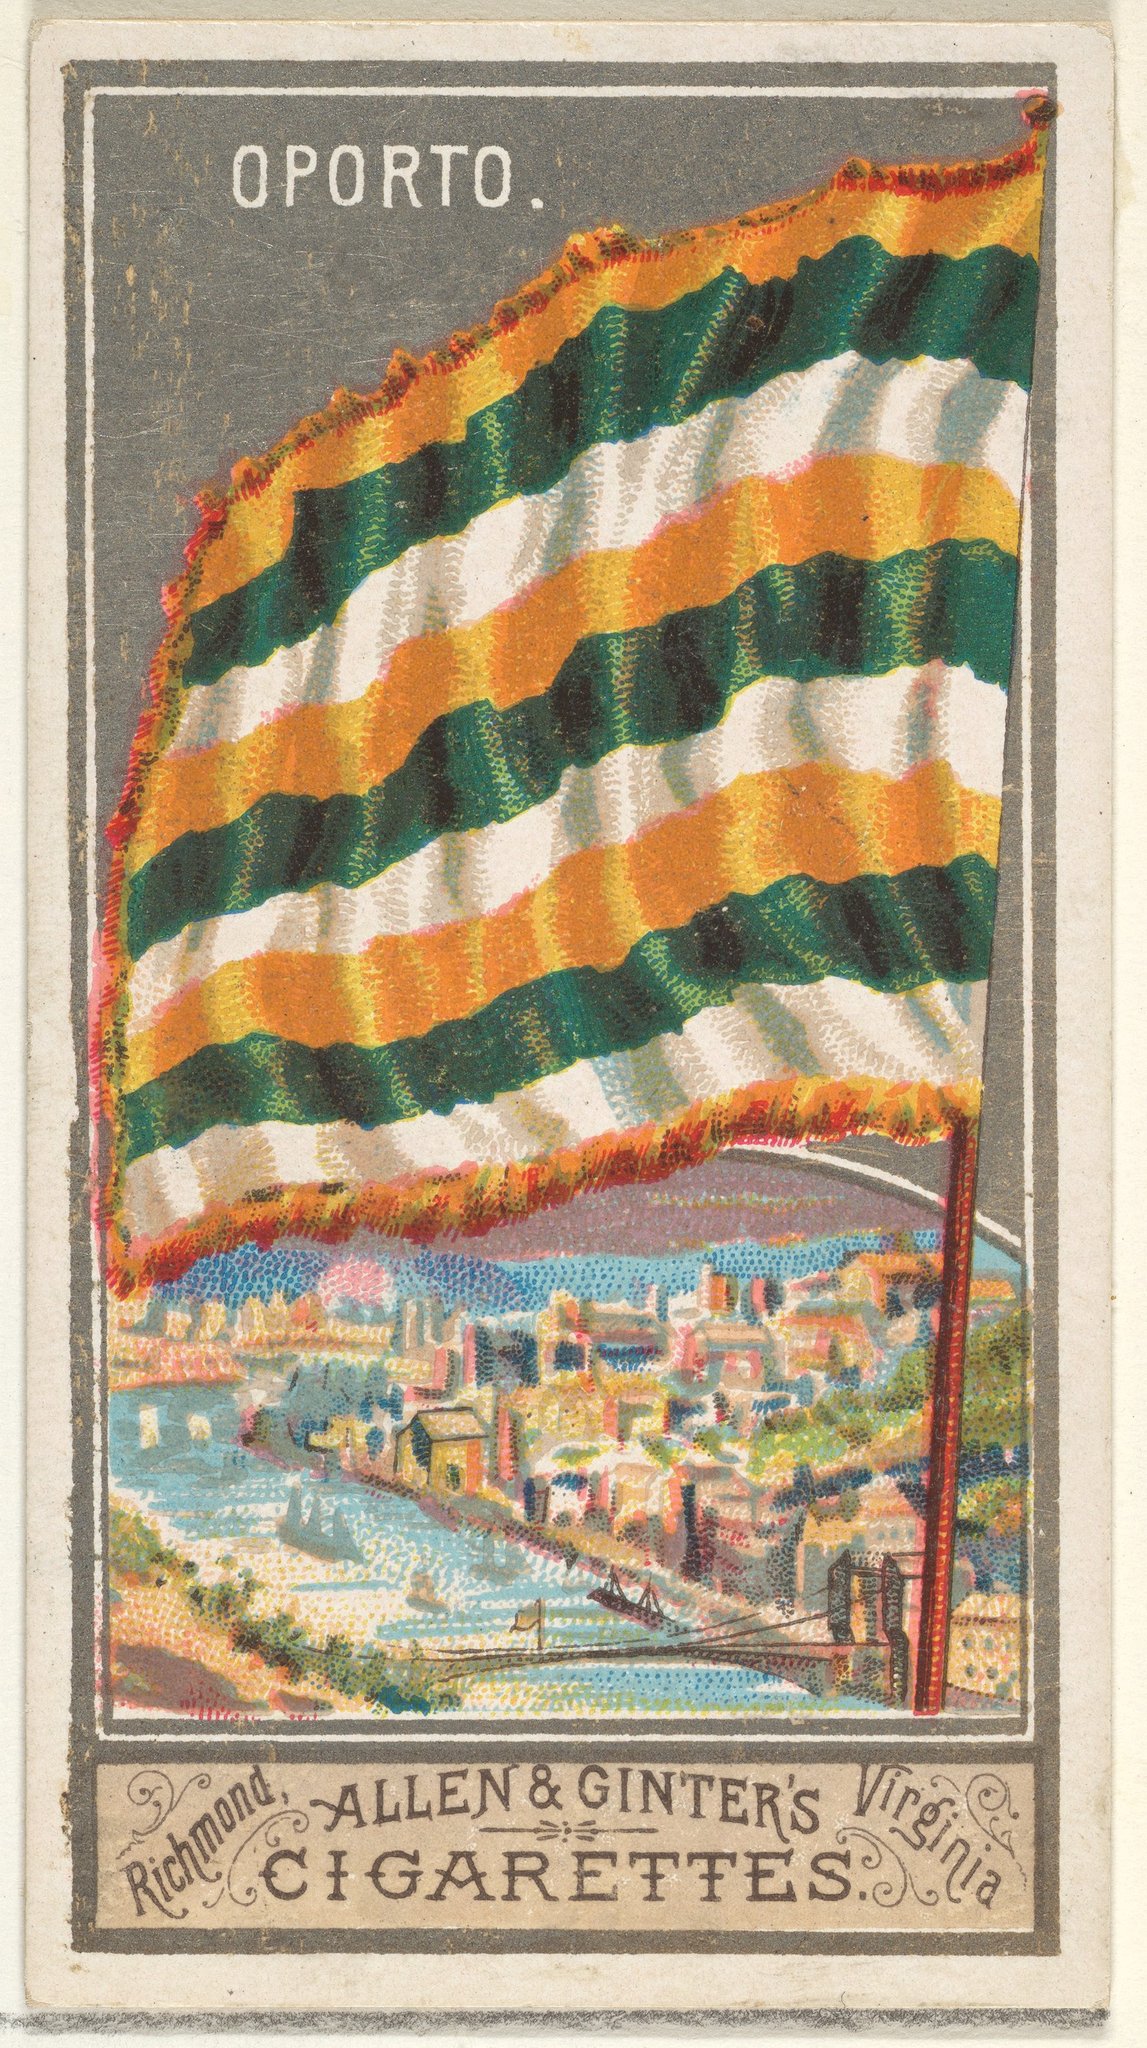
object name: print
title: Oporto, from the City Flags series (N6) for Allen & Ginter Cigarettes Brands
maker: allen & ginter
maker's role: publisher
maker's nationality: american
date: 1887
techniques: color lithograph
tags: cities,flags